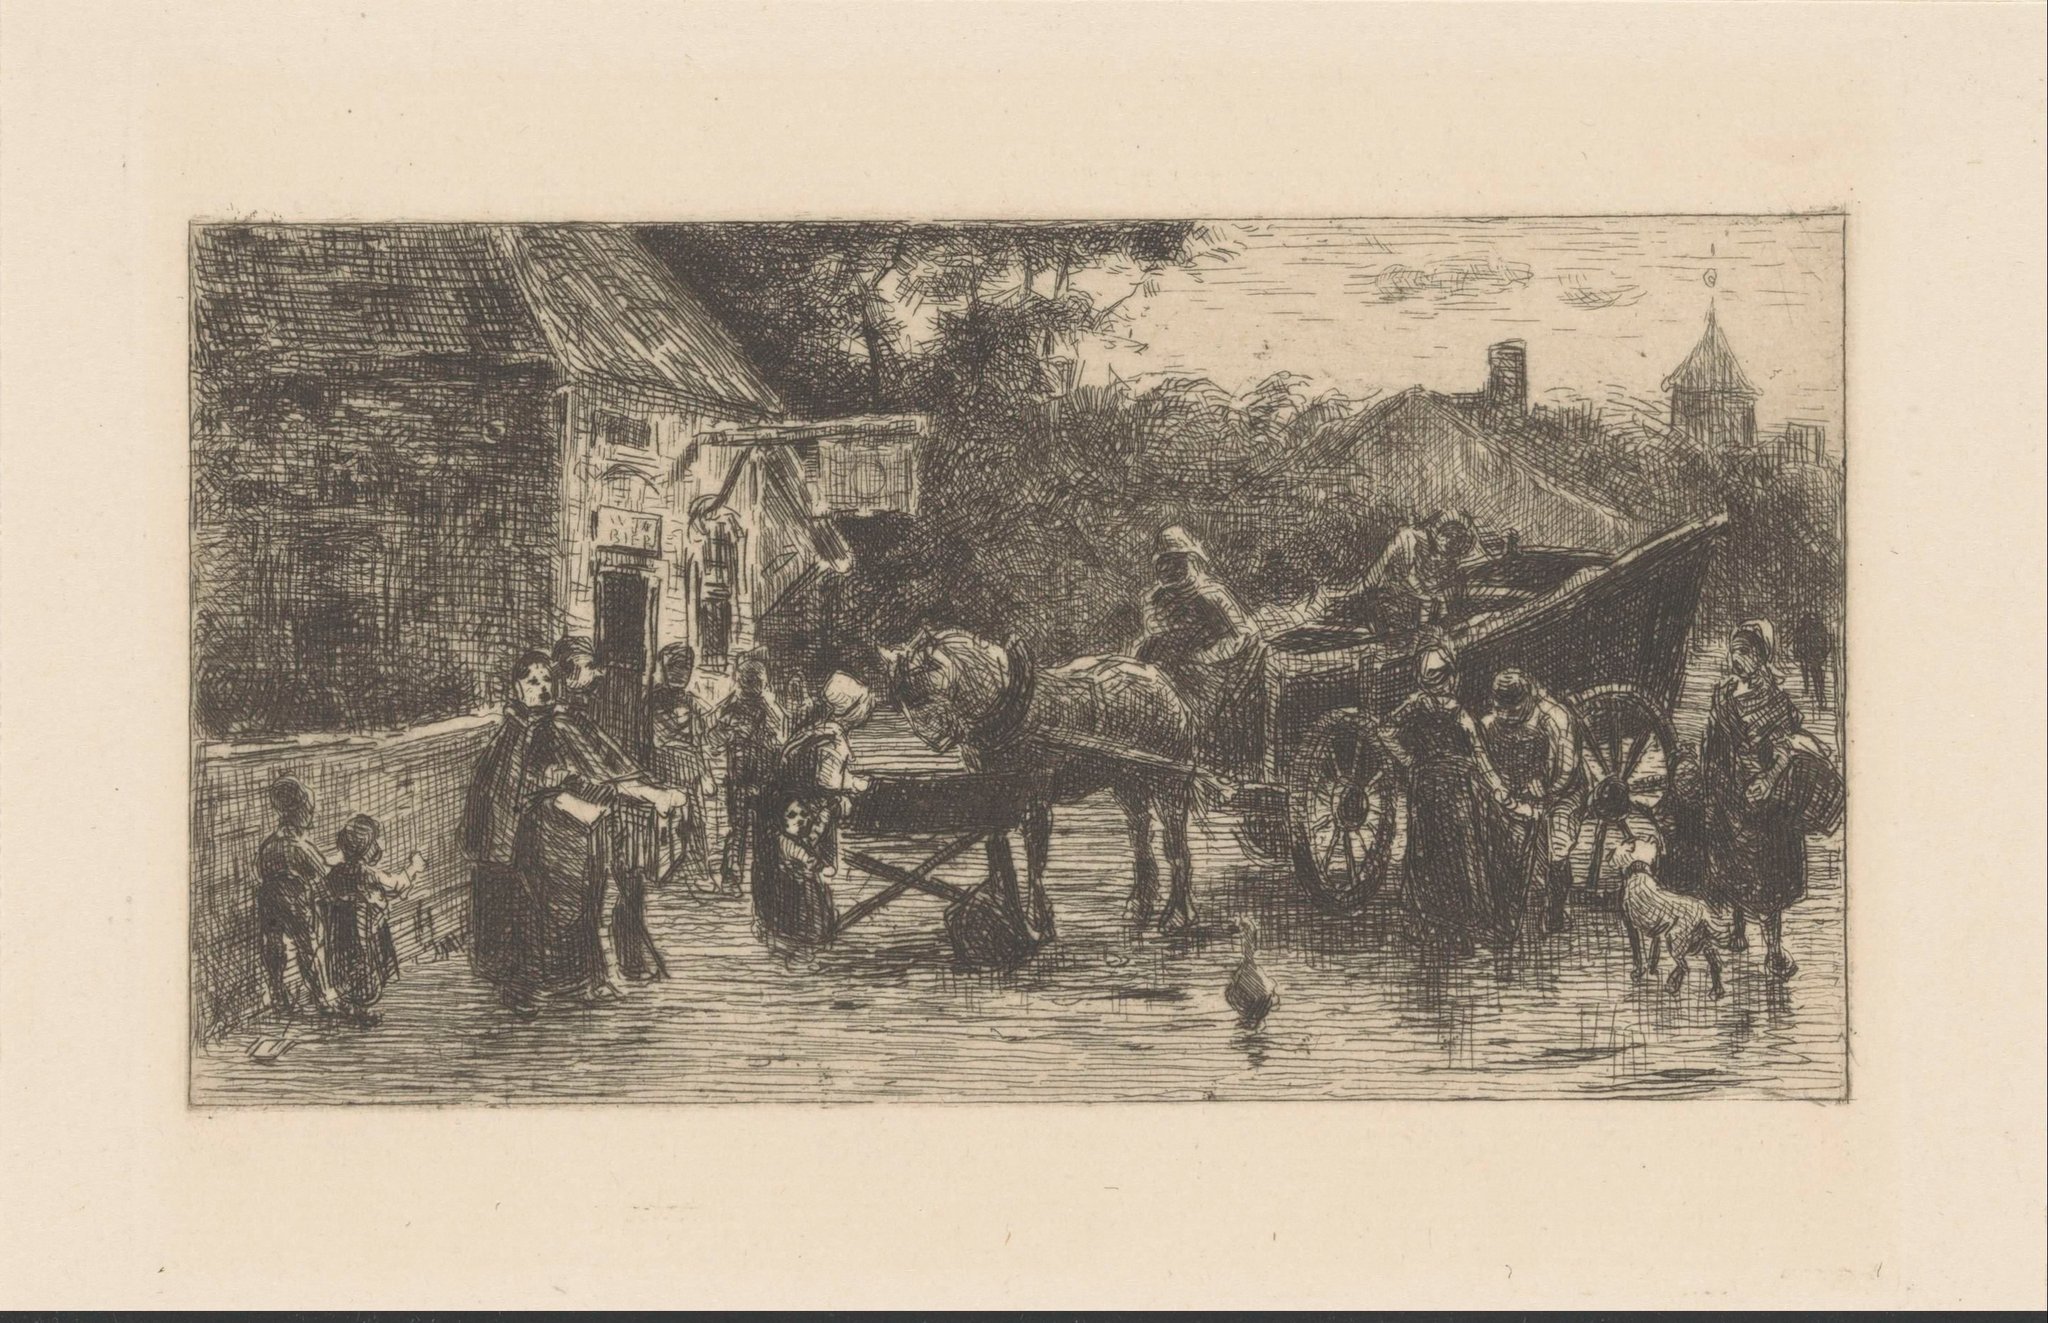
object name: print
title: Figuren bij een paardenkoets op straat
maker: jan de jong (1864-1901)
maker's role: draughtsman, print maker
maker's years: 1864-1901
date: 1874-1901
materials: paper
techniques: etching, intaglio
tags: four-wheeled vehicle drawn by one animal, inn, coffee-house, public house, etc., horse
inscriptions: collector's mark: Lugt 2228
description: Links een gebouw met boven de voordeur de tekst 'BIER'.